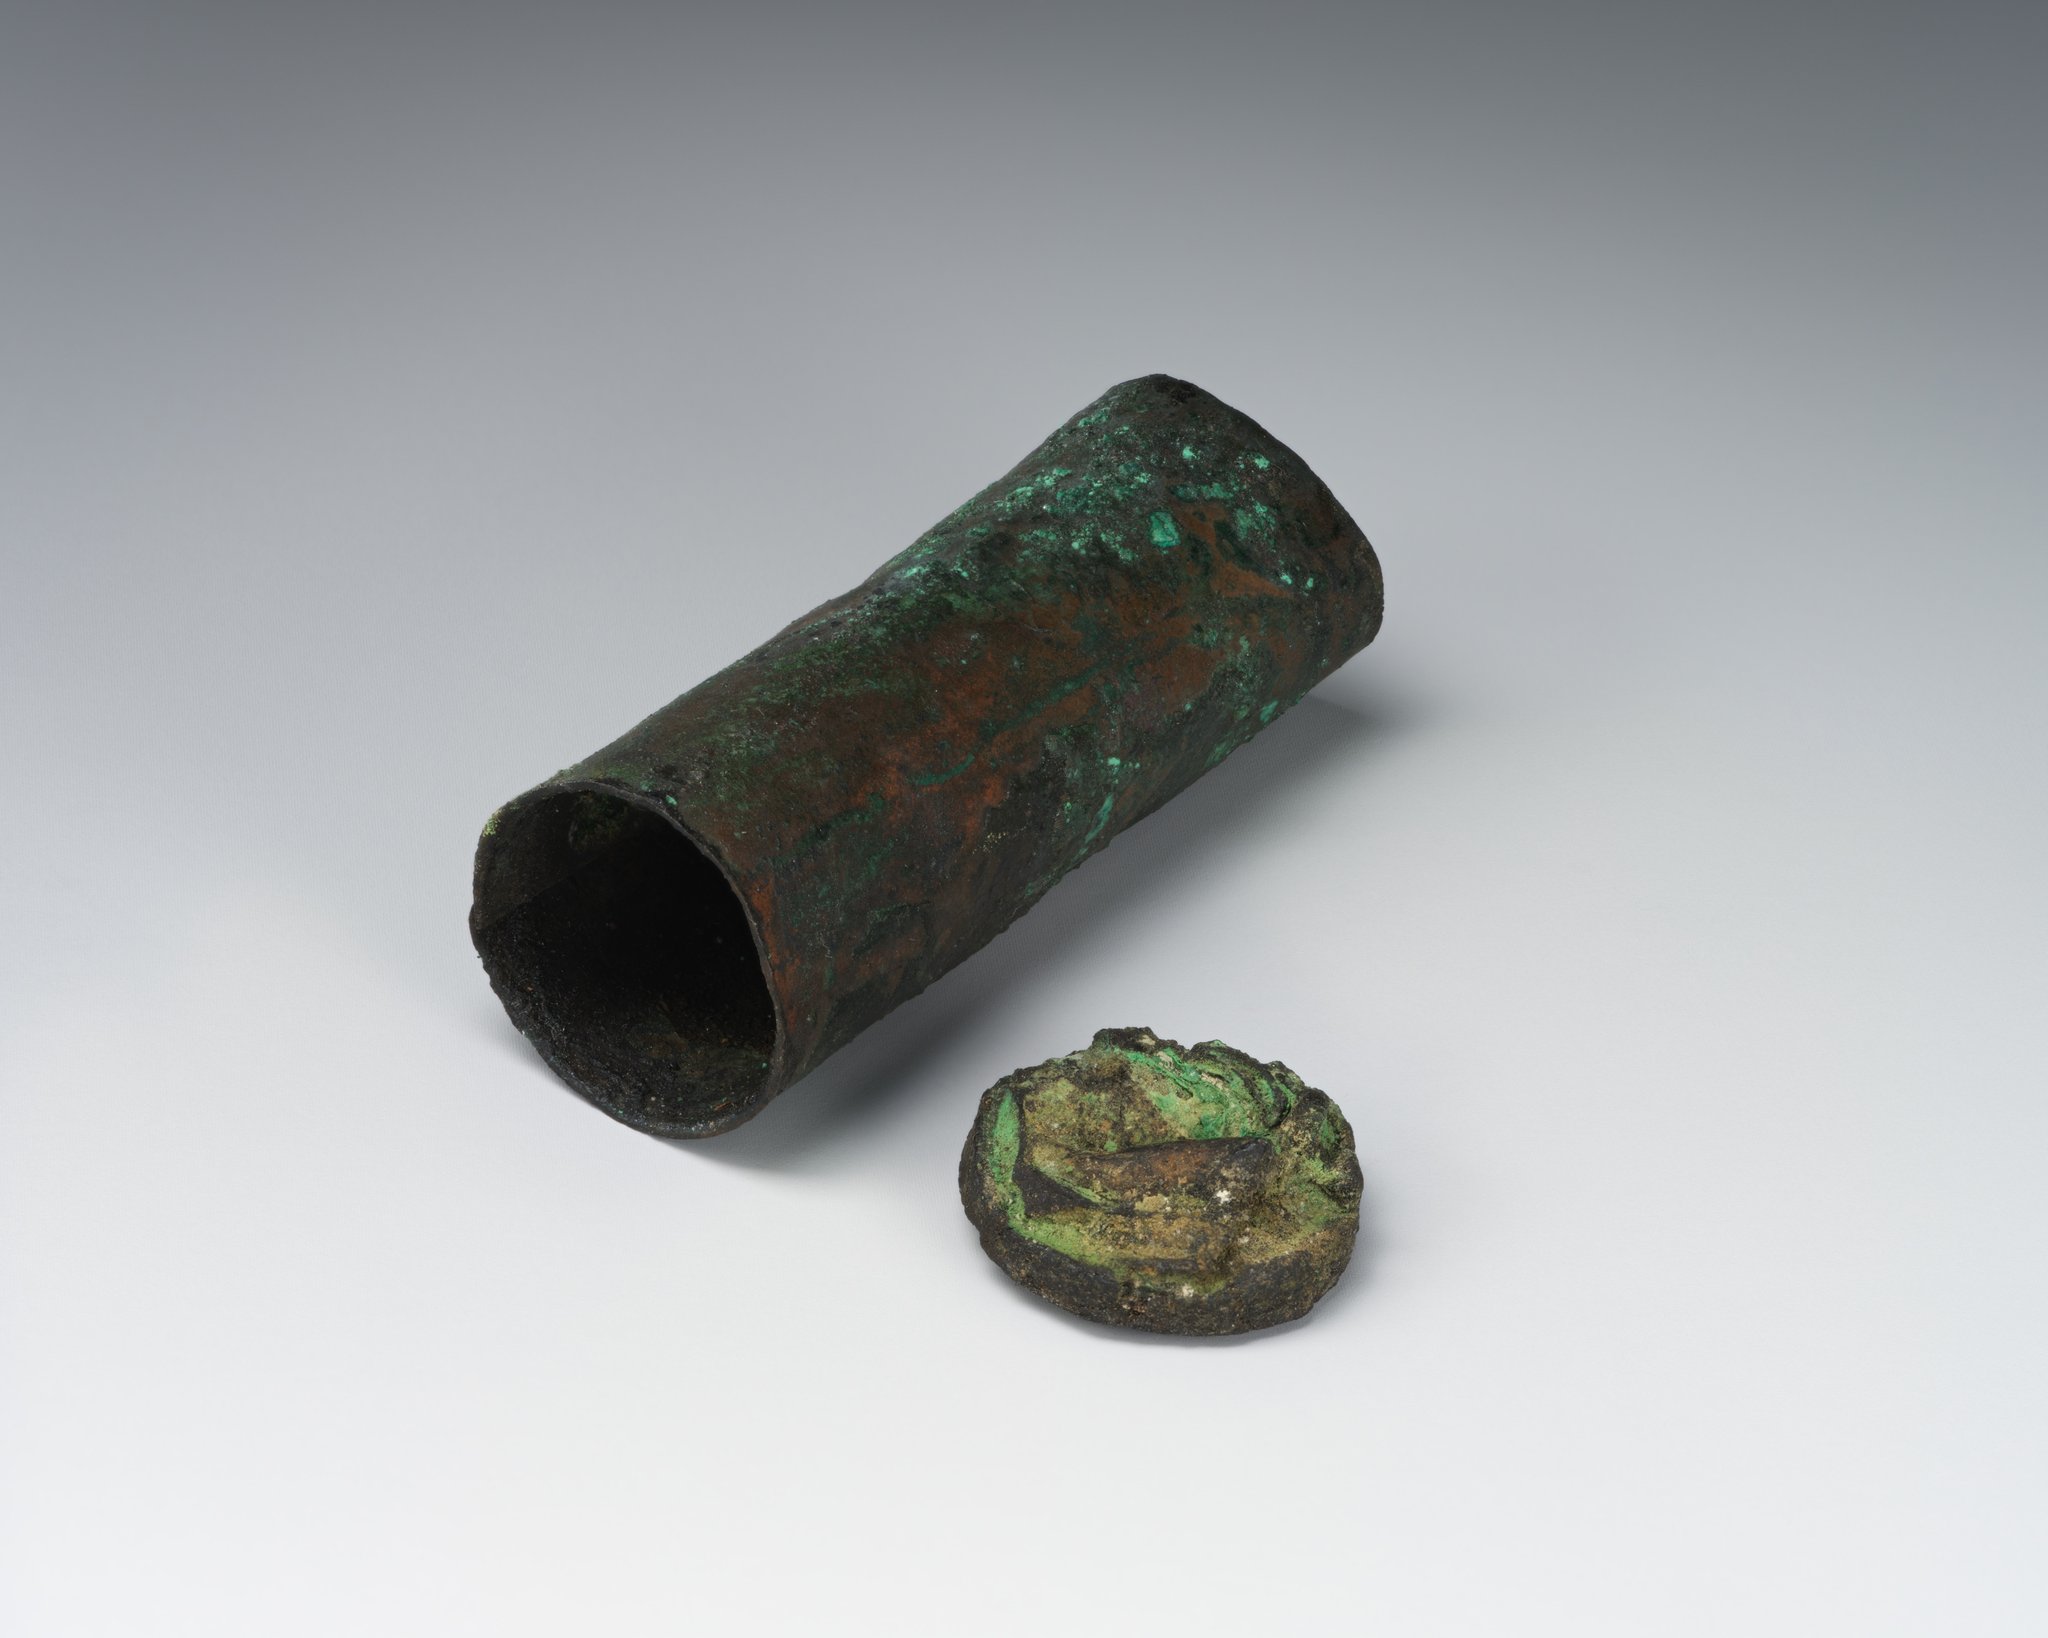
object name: amulet case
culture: sasanian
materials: copper, patina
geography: mesopotamia